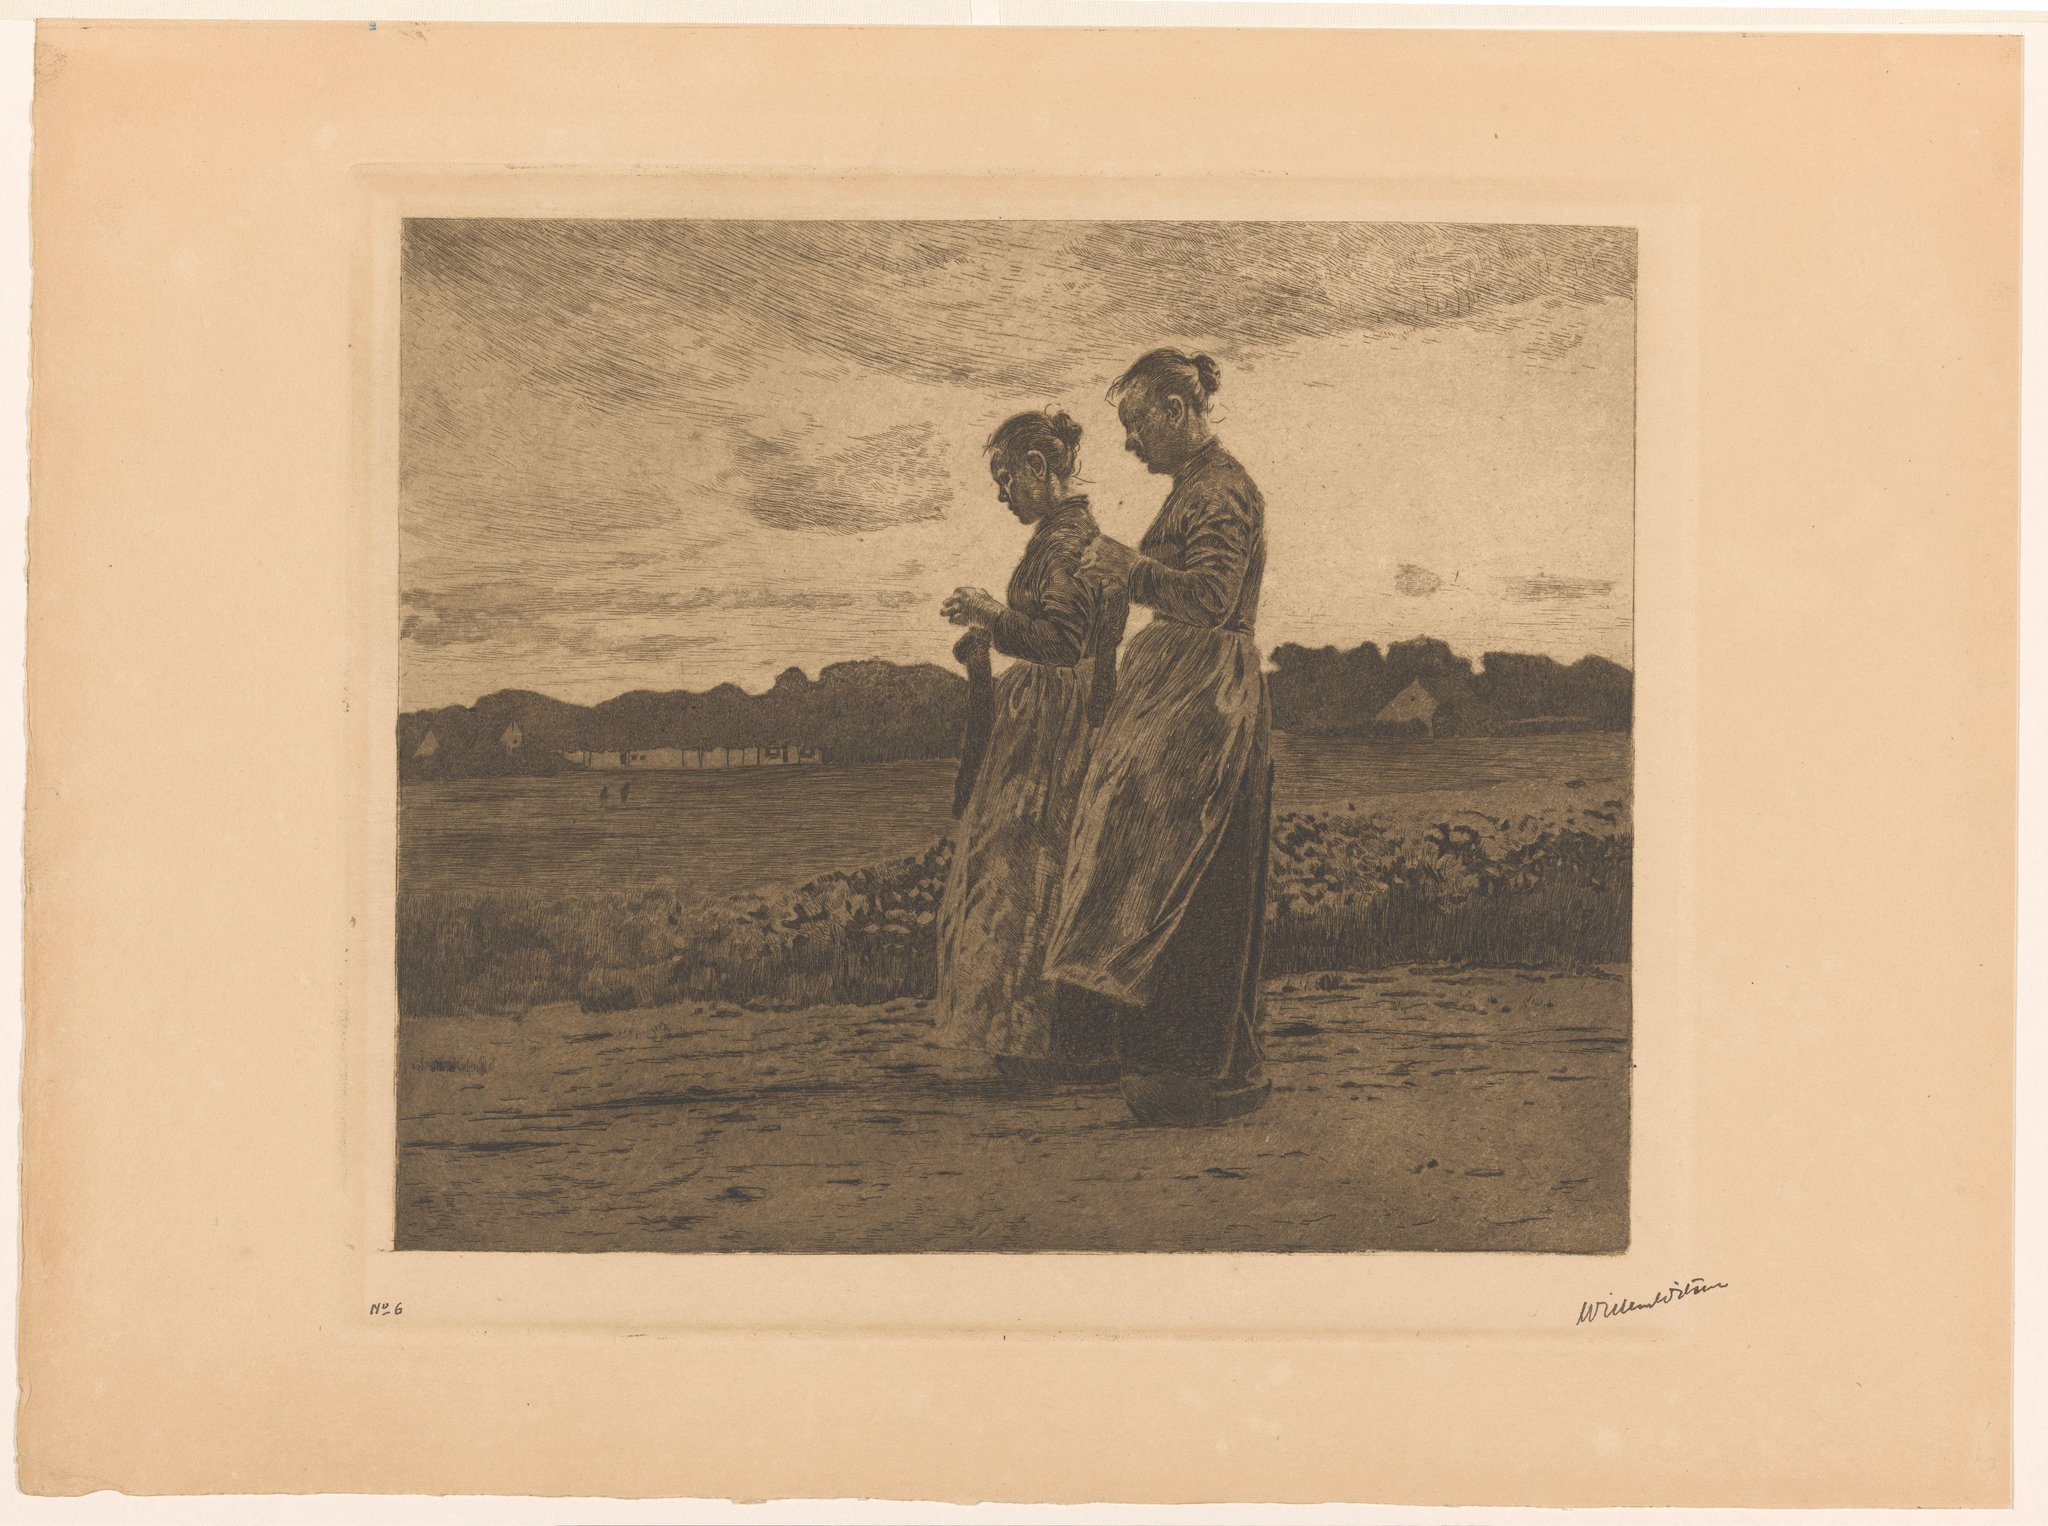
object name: print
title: Twee staande breisters in een landschap in Ede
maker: willem witsen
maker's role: draughtsman, painter, print maker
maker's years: 1860-1923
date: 1897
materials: paper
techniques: aquatint, etching, intaglio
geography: ede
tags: landscapes in the temperate zone - hh - ideal landscapes, standing figure - aa - female human figure, knitting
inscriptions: collector's mark: Lugt 2228, inscription: ‘No. 6’, signature: ‘Willem Witsen’